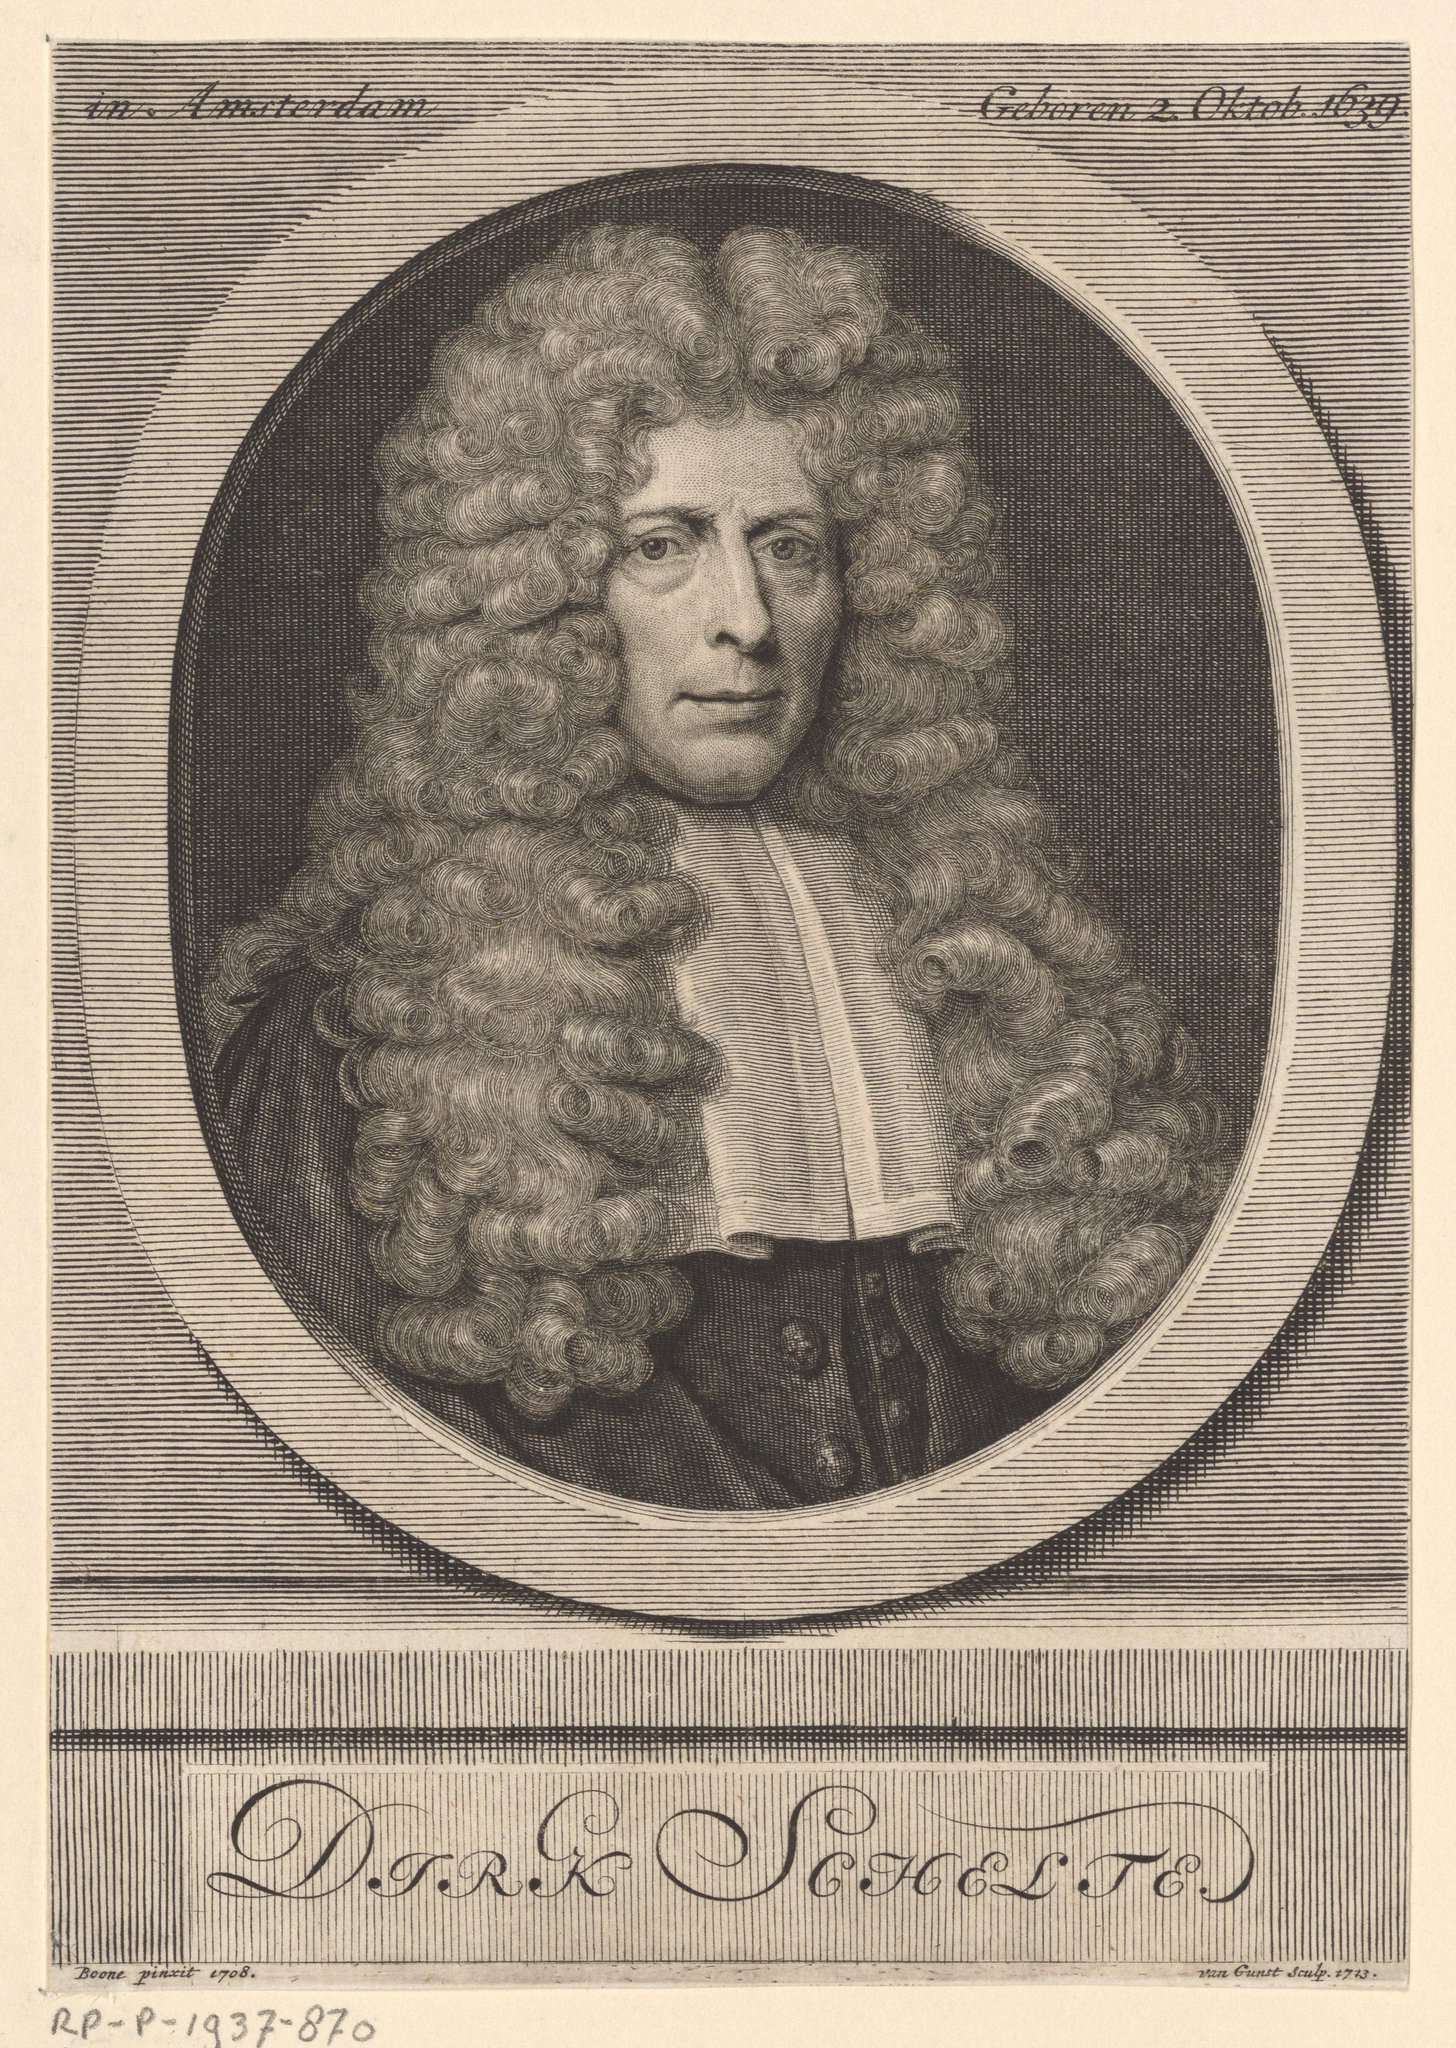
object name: print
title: Portret van Dirk Schelte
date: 1713-1714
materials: paper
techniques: engraving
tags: dirk schelte, historical persons, writer, poet, author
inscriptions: collector's mark: Lugt 2228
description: Prent waarschijnlijk uit: Schelte, Dirk. De Rym-werken (...). Amsterdam: Hendrik Schelte, 1714.